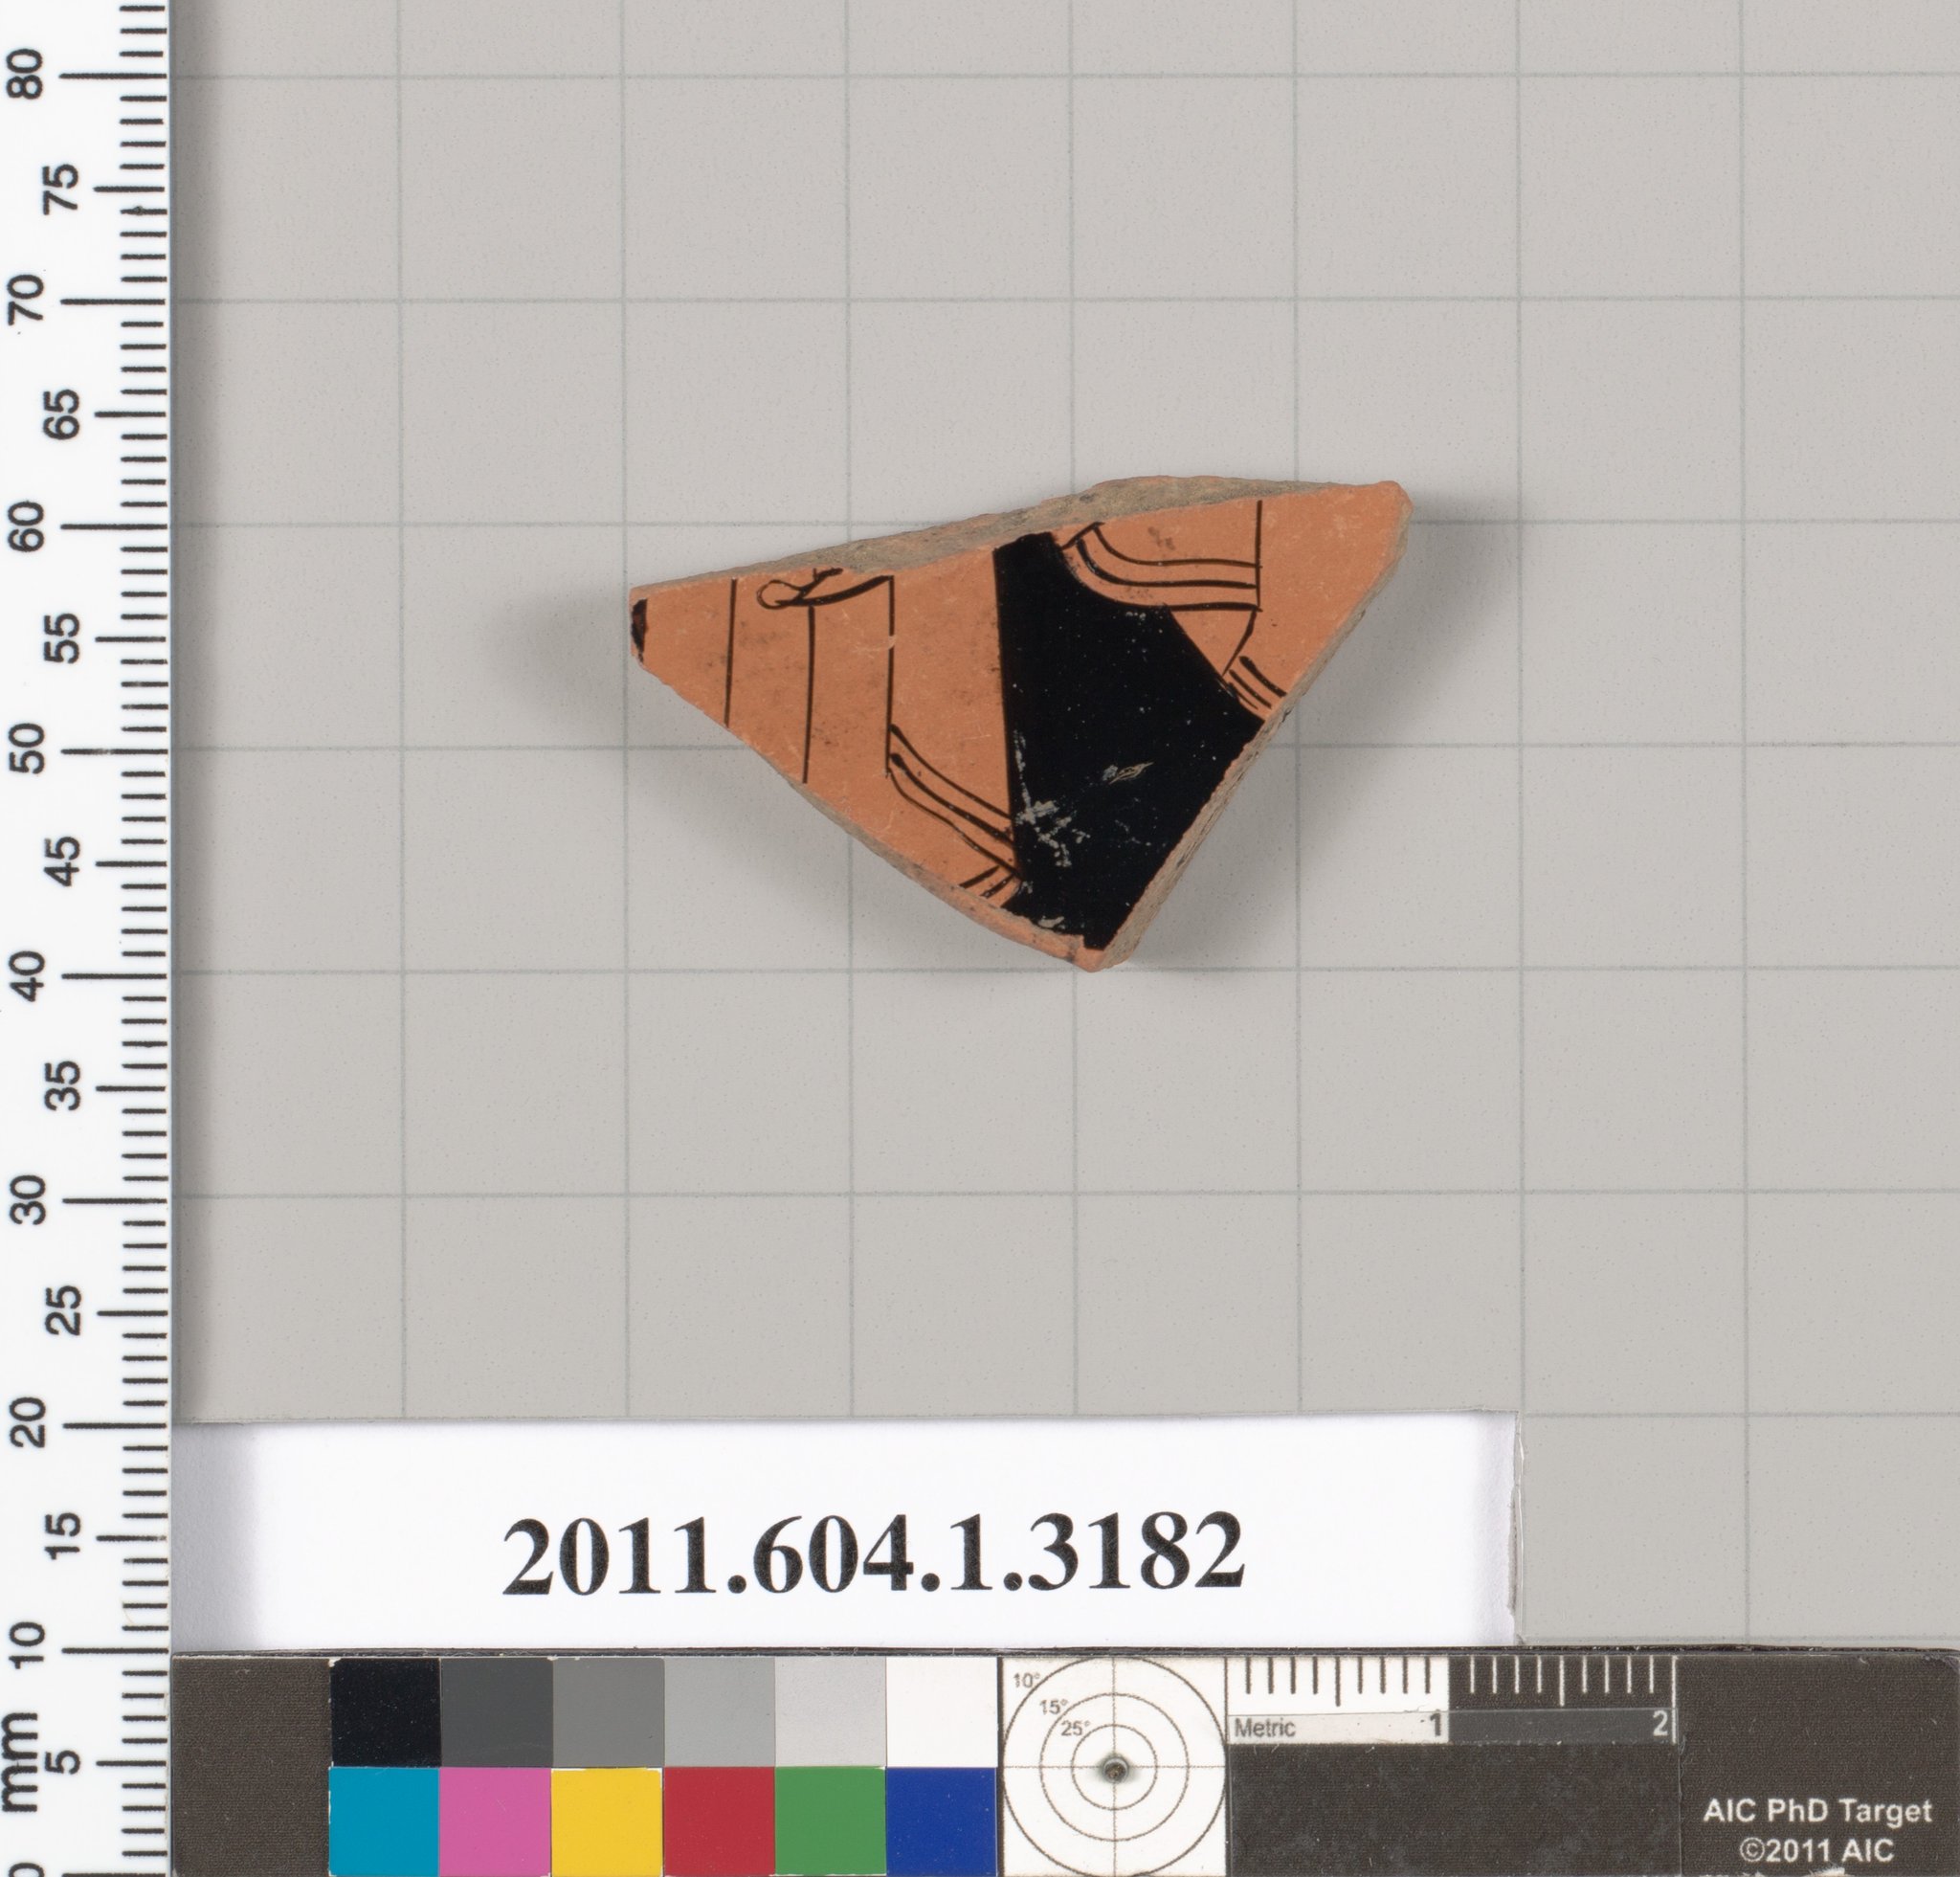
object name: kylix fragment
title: Terracotta fragment of a kylix (drinking cup)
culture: greek, attic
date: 490-480 BCE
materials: terracotta